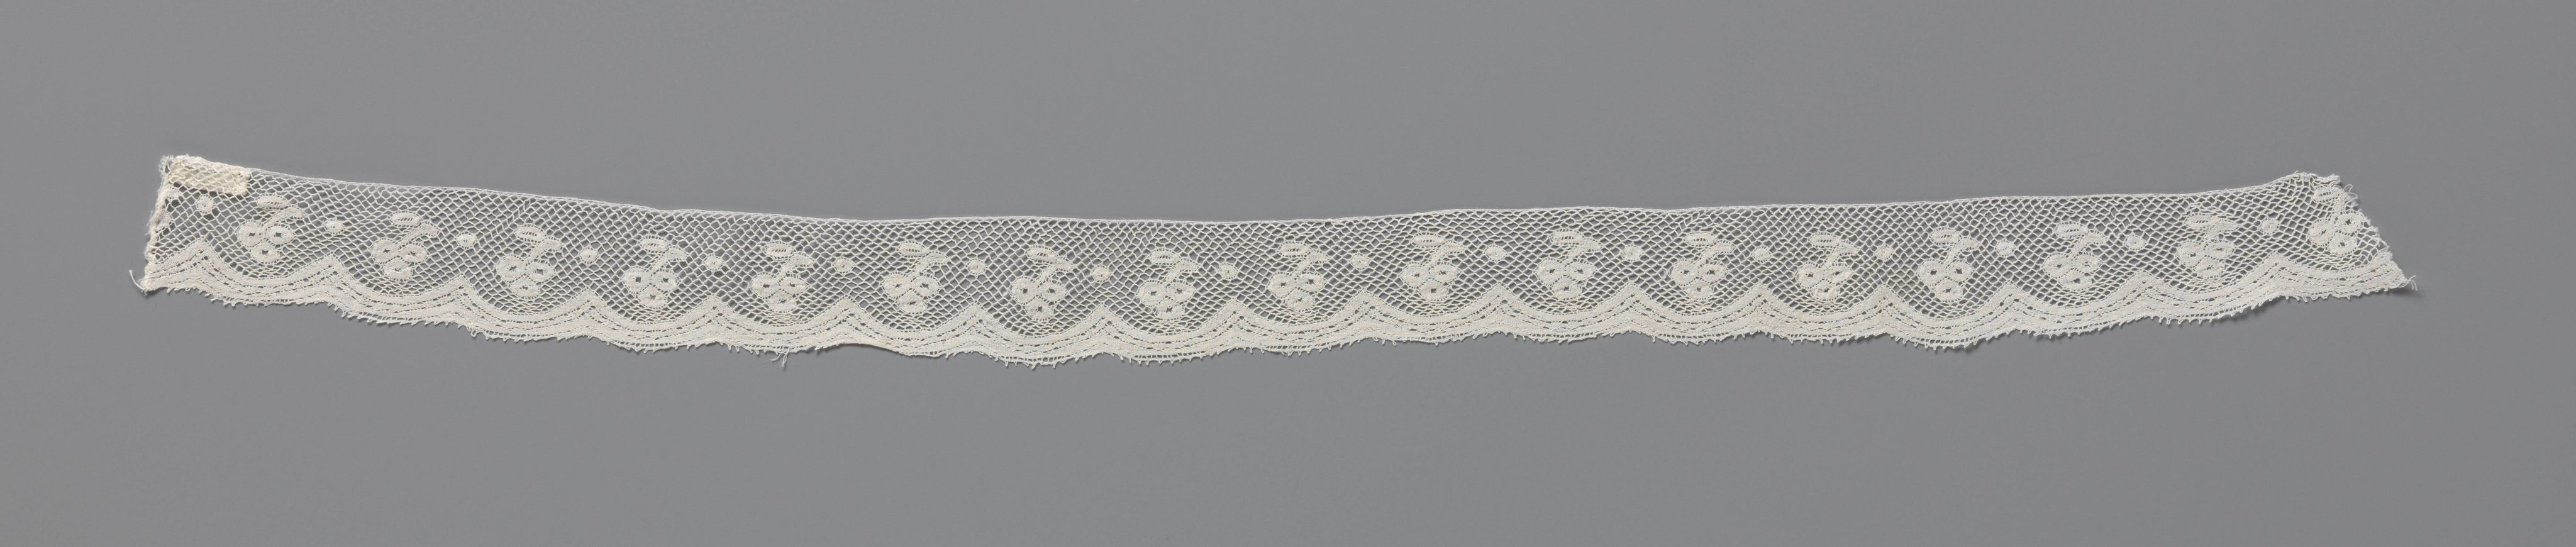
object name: strip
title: Strook kloskant met drie besjes aan een takje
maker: Anonymous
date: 1875-1899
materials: linen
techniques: lace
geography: ieper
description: Op een fond van vierkante mazen staan boven een brede en gesloten schulprand stijve takjes, waaraan drie besjes groeien. Tussen elk takje is een moesje geplaatst. Valenciennes-kant.